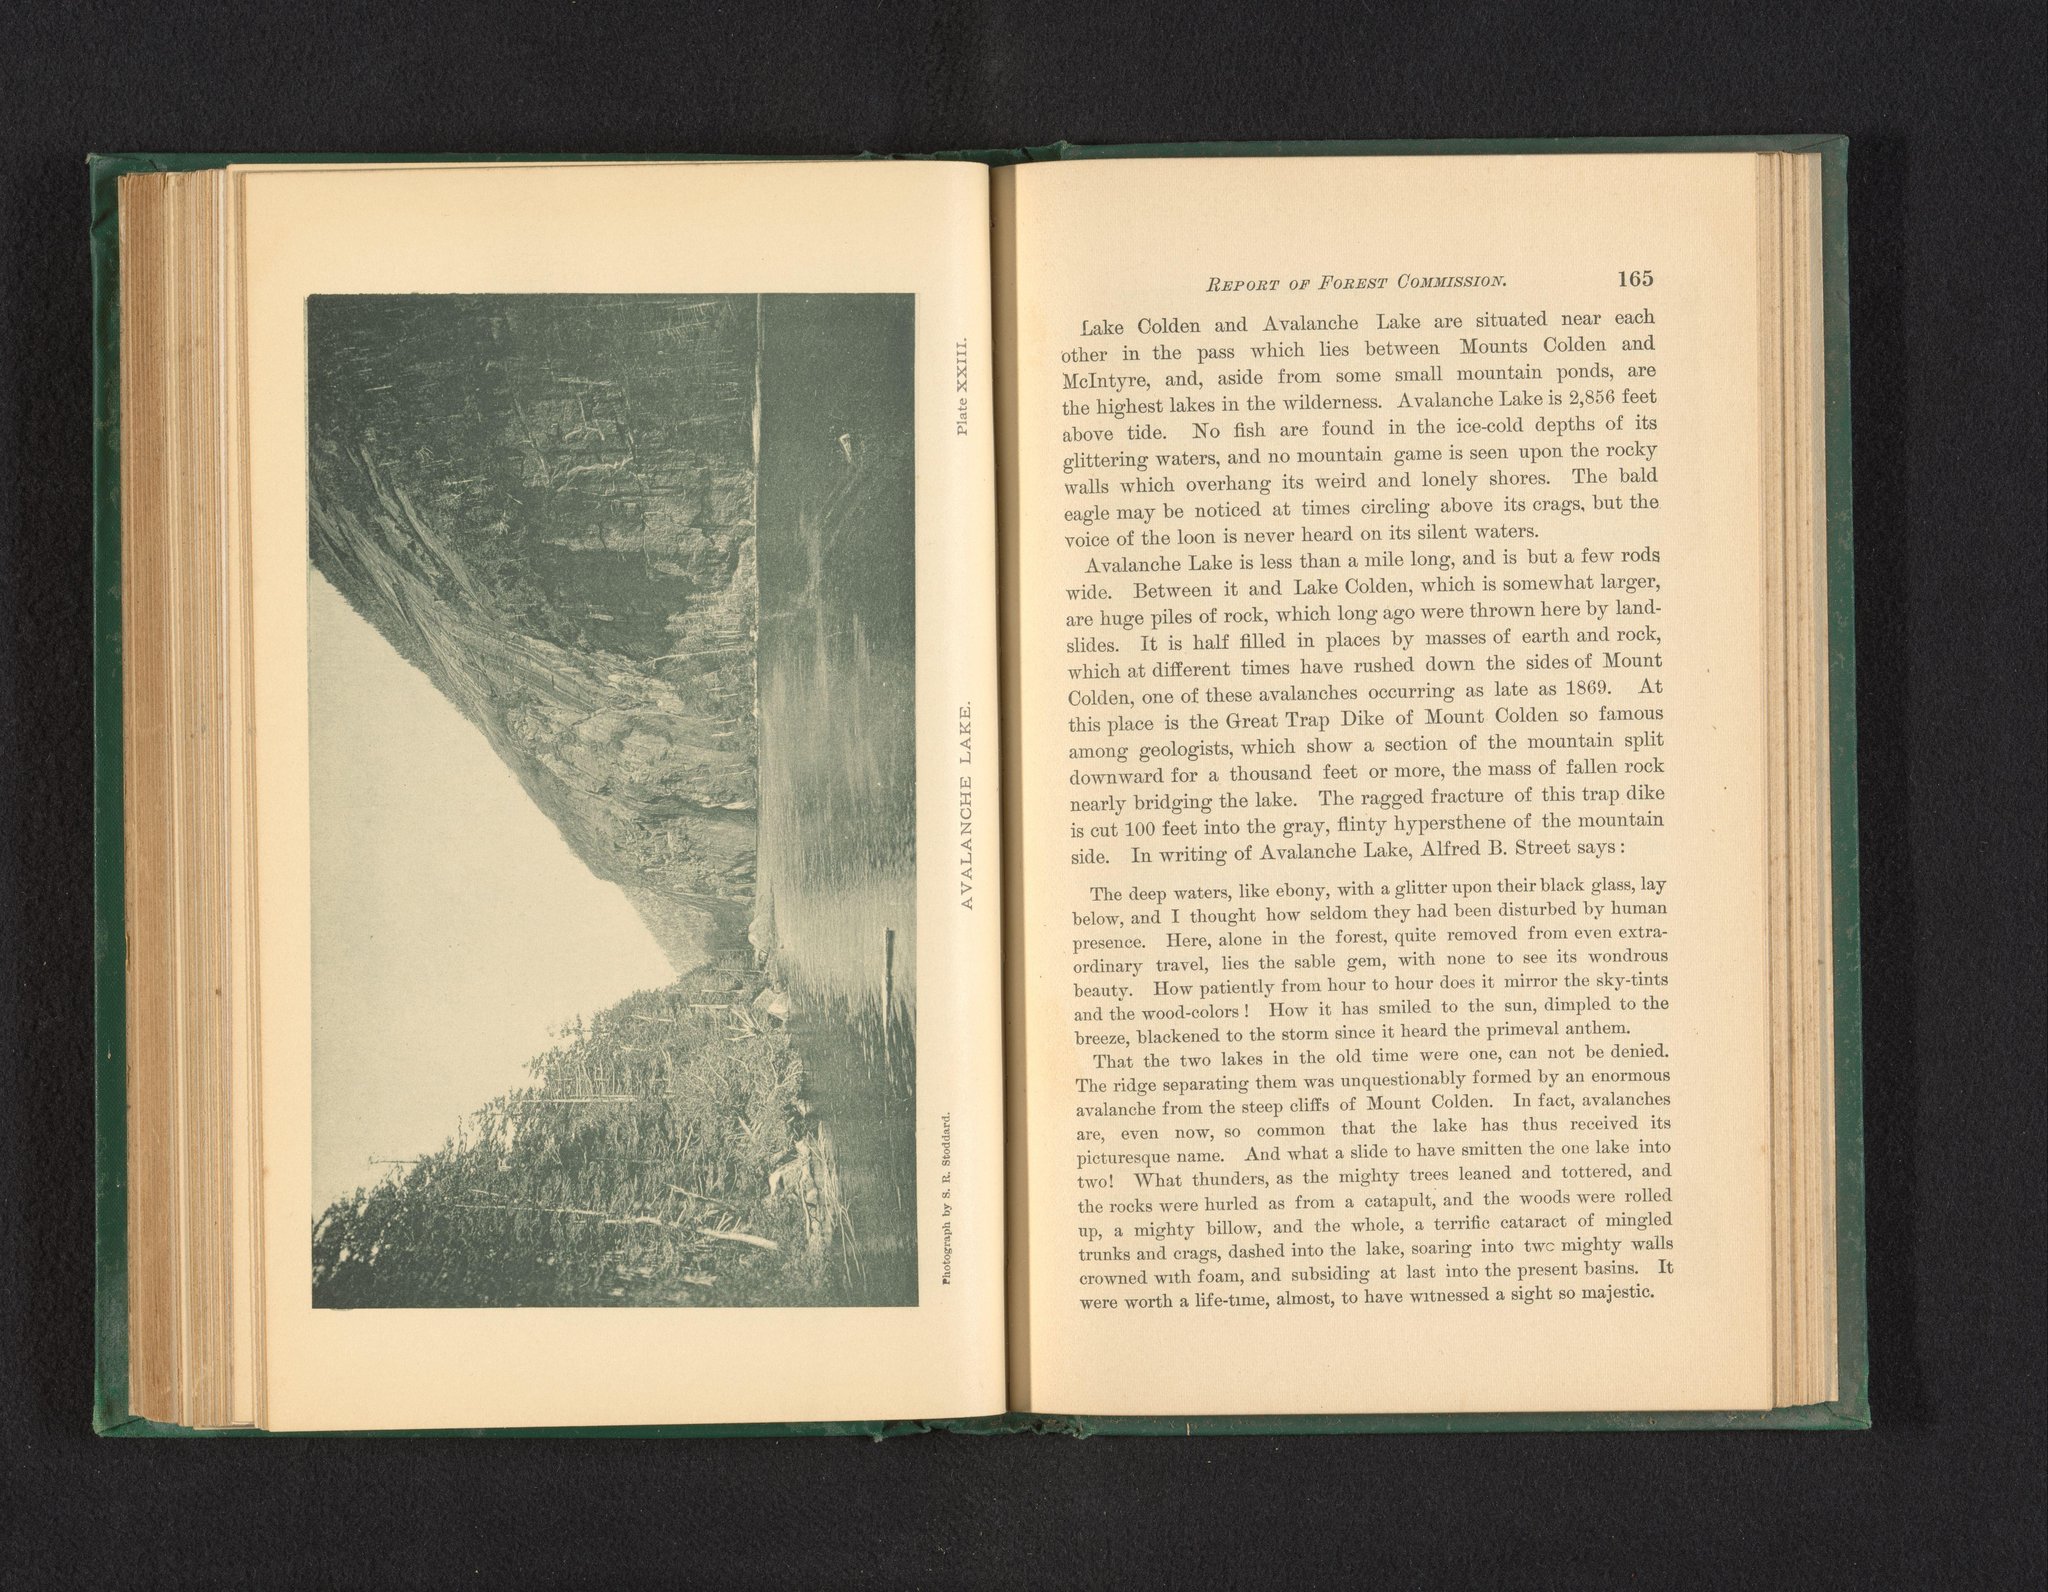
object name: page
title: Avalanche Lake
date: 1891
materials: paper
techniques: photograph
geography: new york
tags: lake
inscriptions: number: ‘Plate XXIII.’